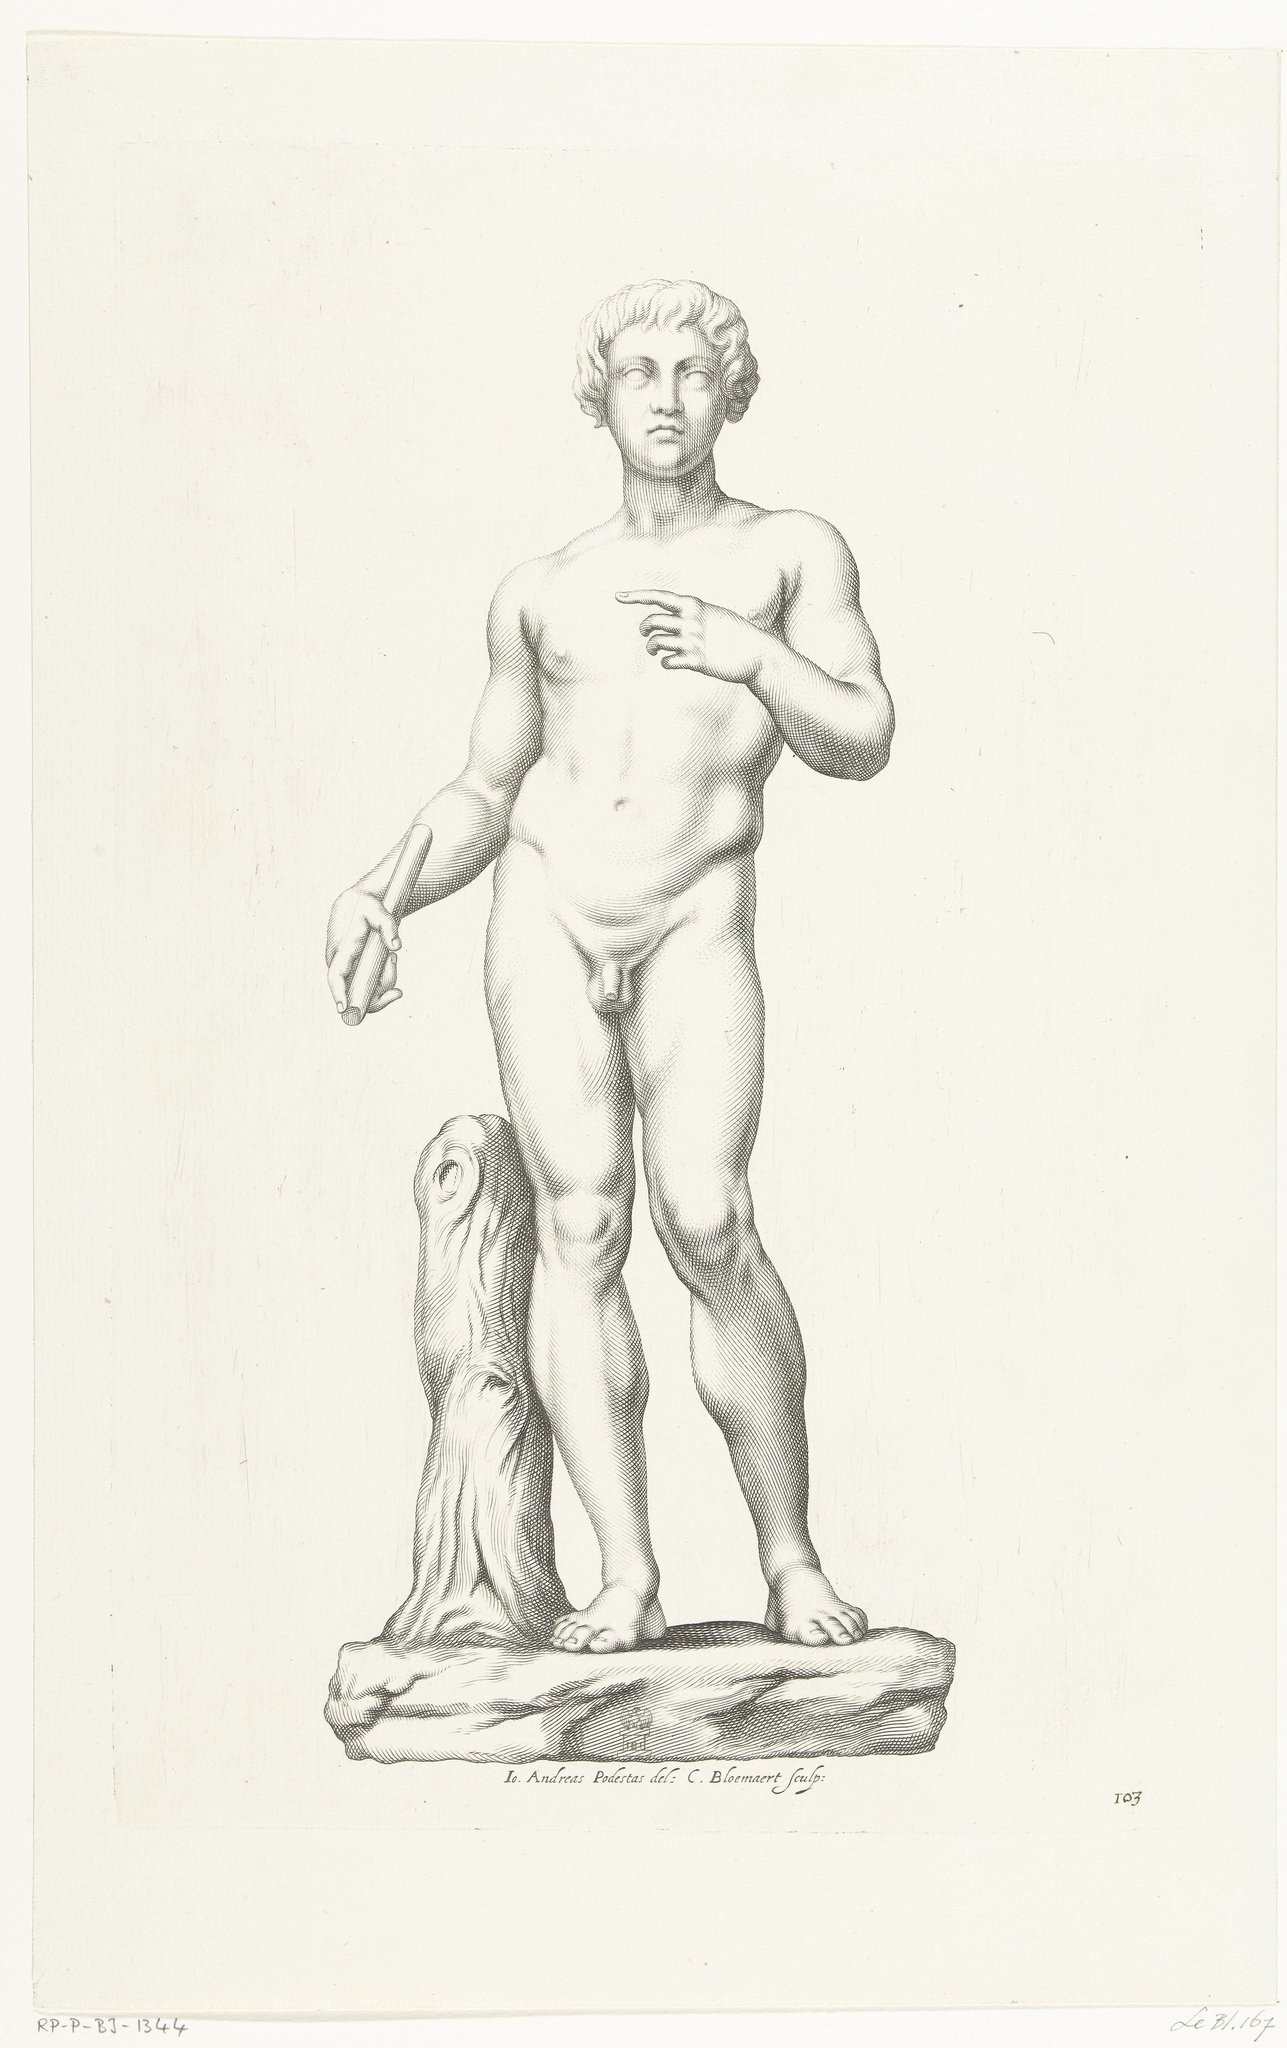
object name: print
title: Jongen met officiersstokje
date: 1636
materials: paper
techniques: engraving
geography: rome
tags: the (nude) human figure; 'corpo humano' (ripa) (+ young male (human being)), piece of sculpture, reproduction of a piece of sculpture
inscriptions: number: ‘103’, collector's mark: Lugt 2228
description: Beeld van een naakte jongen met een officiersstokje in zijn hand. Het beeld is afkomstig uit de collectie van Vincenzo Giustiniani, wiens wapen op de sokkel te zien is.